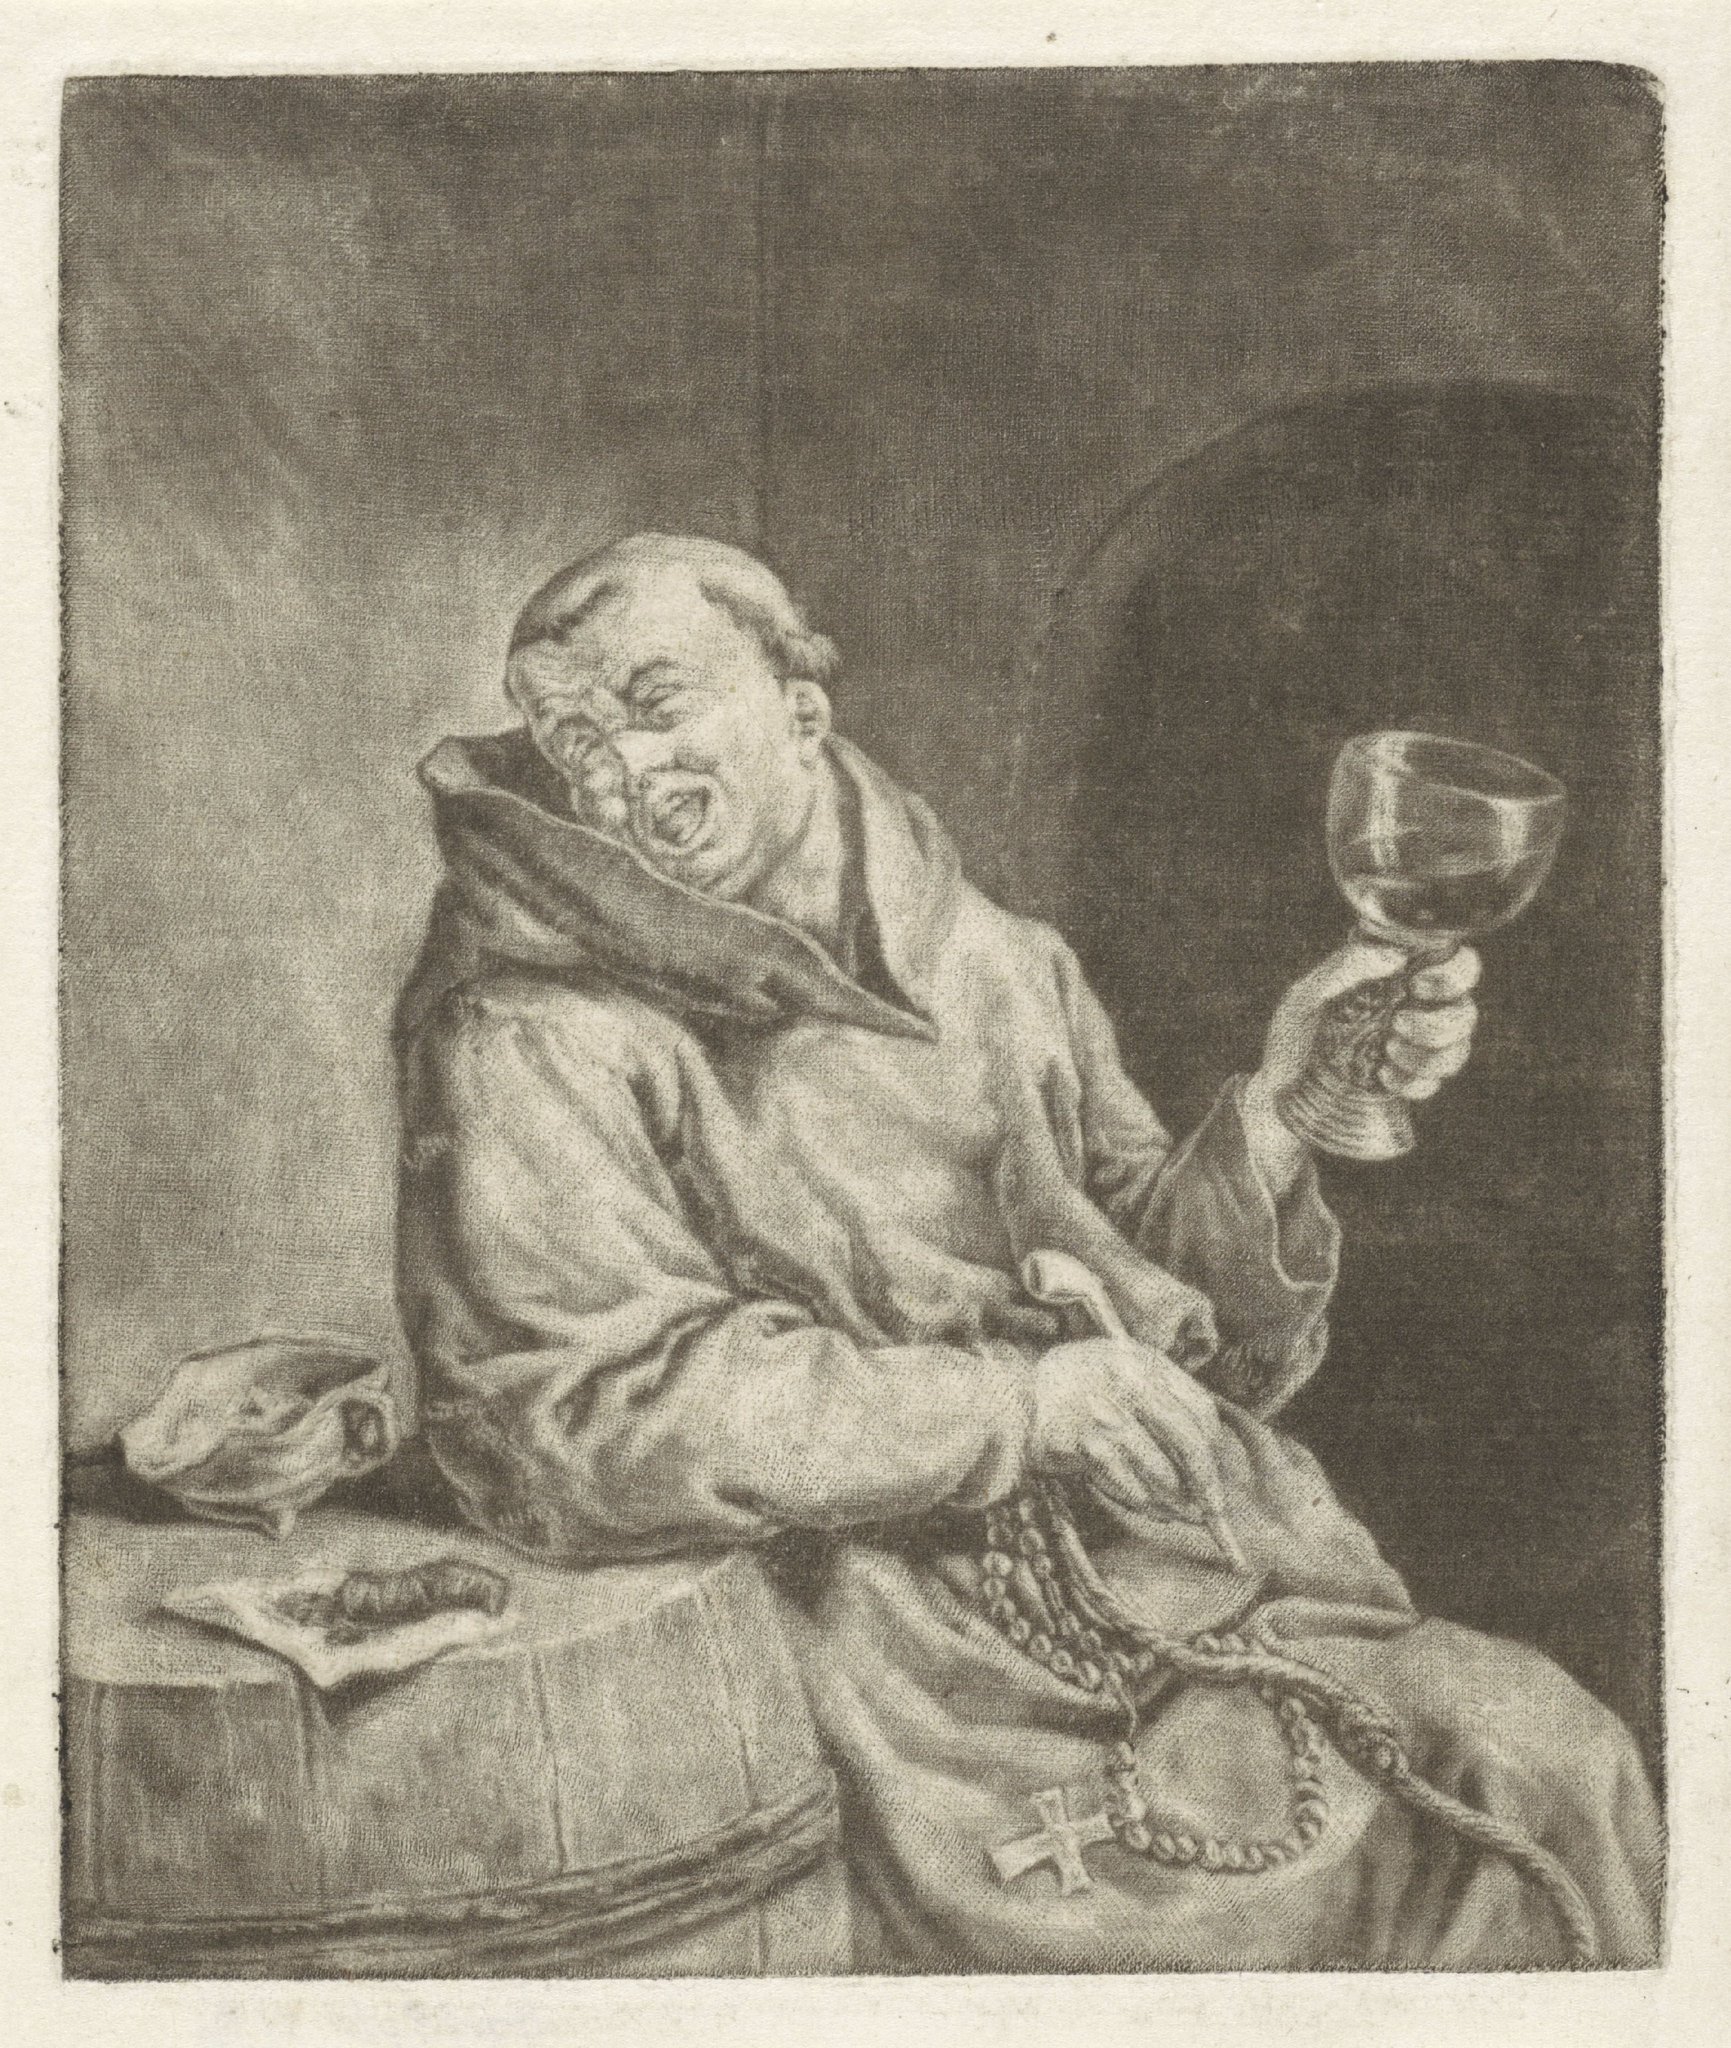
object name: print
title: Smaak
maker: cornelis dusart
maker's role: draughtsman, painter, print maker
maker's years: 1660-1704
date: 1679-1704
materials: paper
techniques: mezzotint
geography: haarlem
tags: taste, tasting (one of the five senses), pipe ~ tobacco, monk(s), friar(s), drunkenness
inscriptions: collector's mark: Lugt 2228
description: Het zintuig Smaak. Een zingende dronken monnik met een roemer en een pijp in de handen.